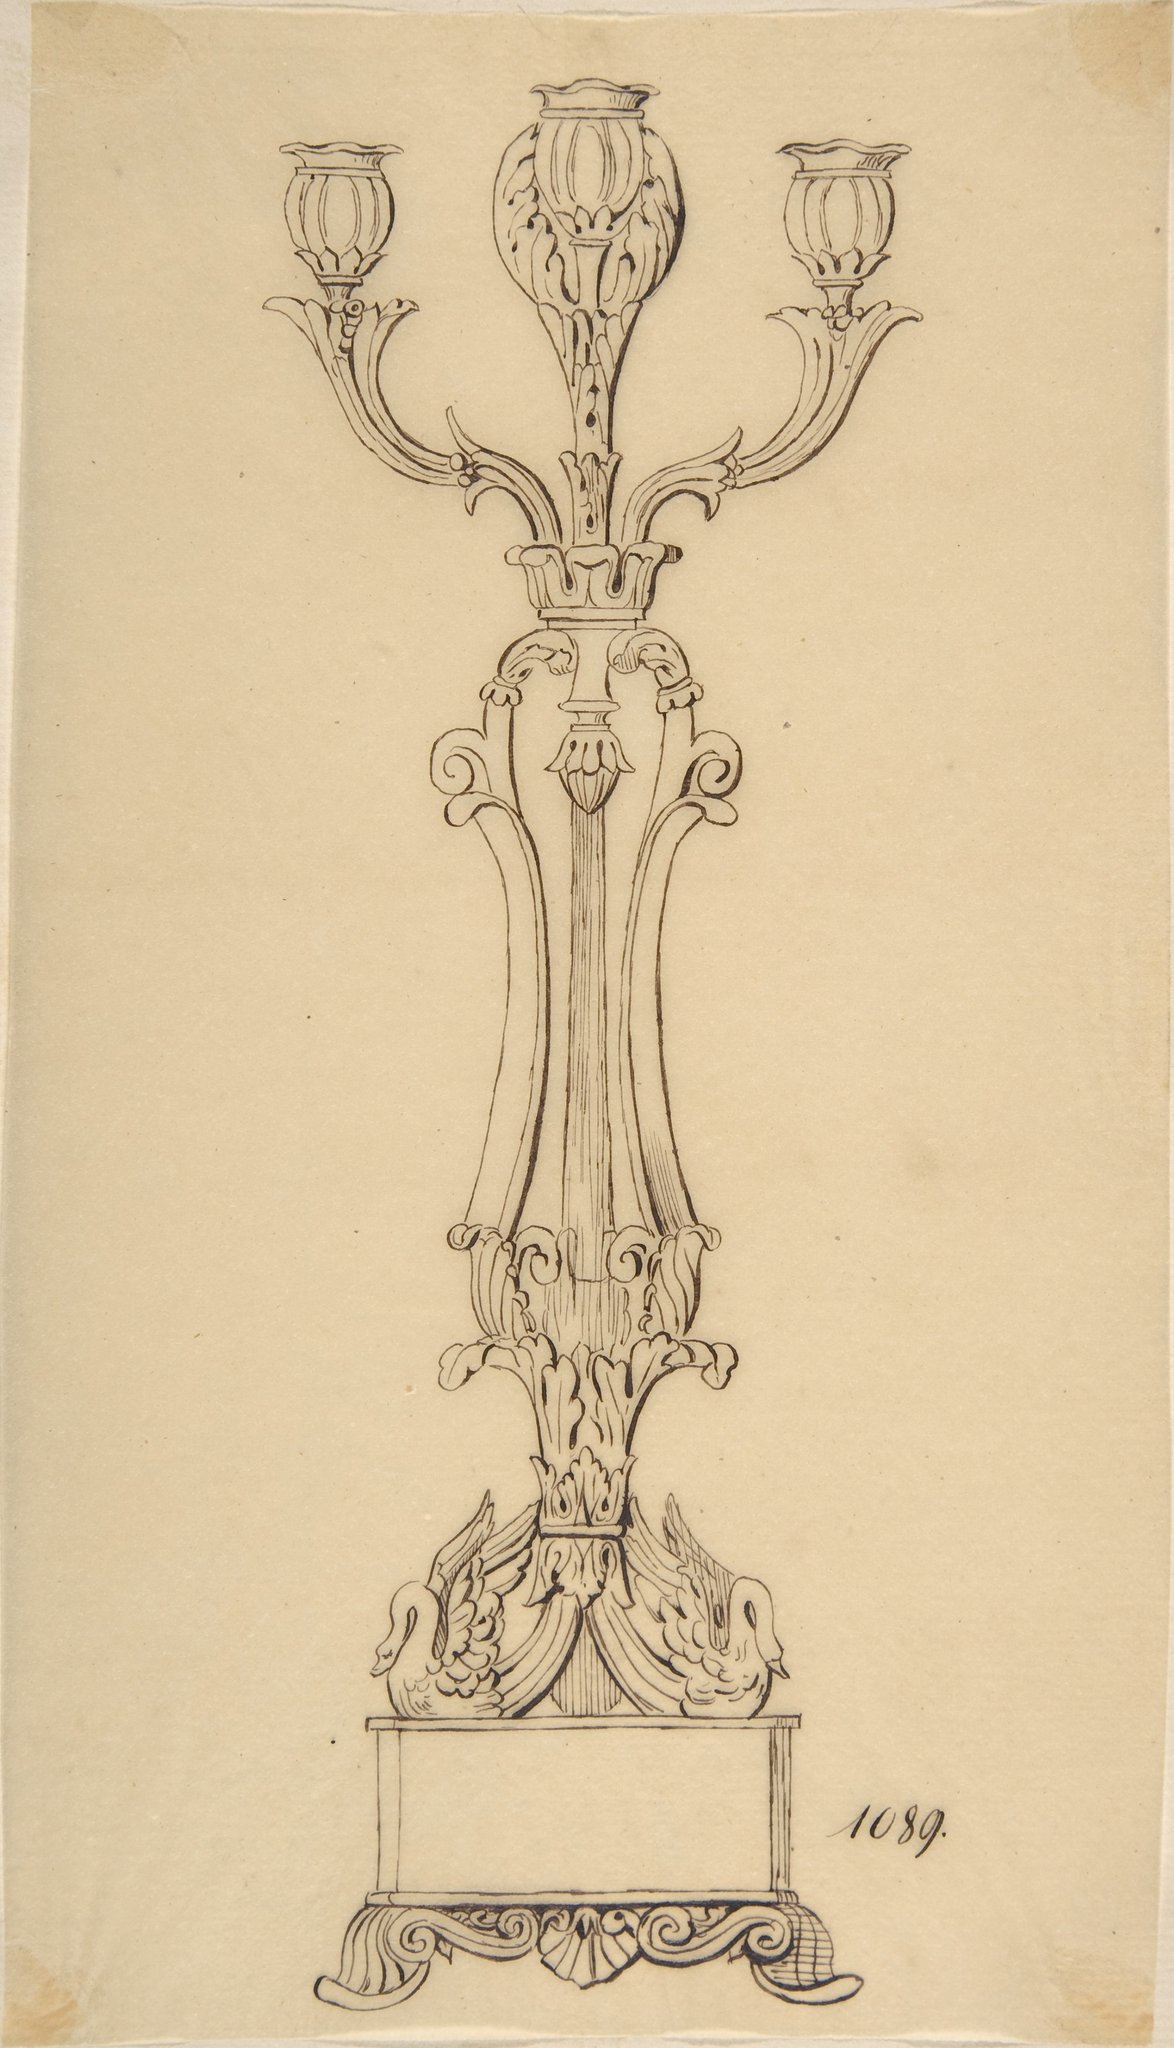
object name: drawing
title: Design for a Candelabra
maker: anonymous, french, 19th century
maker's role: artist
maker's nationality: french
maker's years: 1800-1900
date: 1801-1900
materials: ink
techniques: pen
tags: swans,candelabra